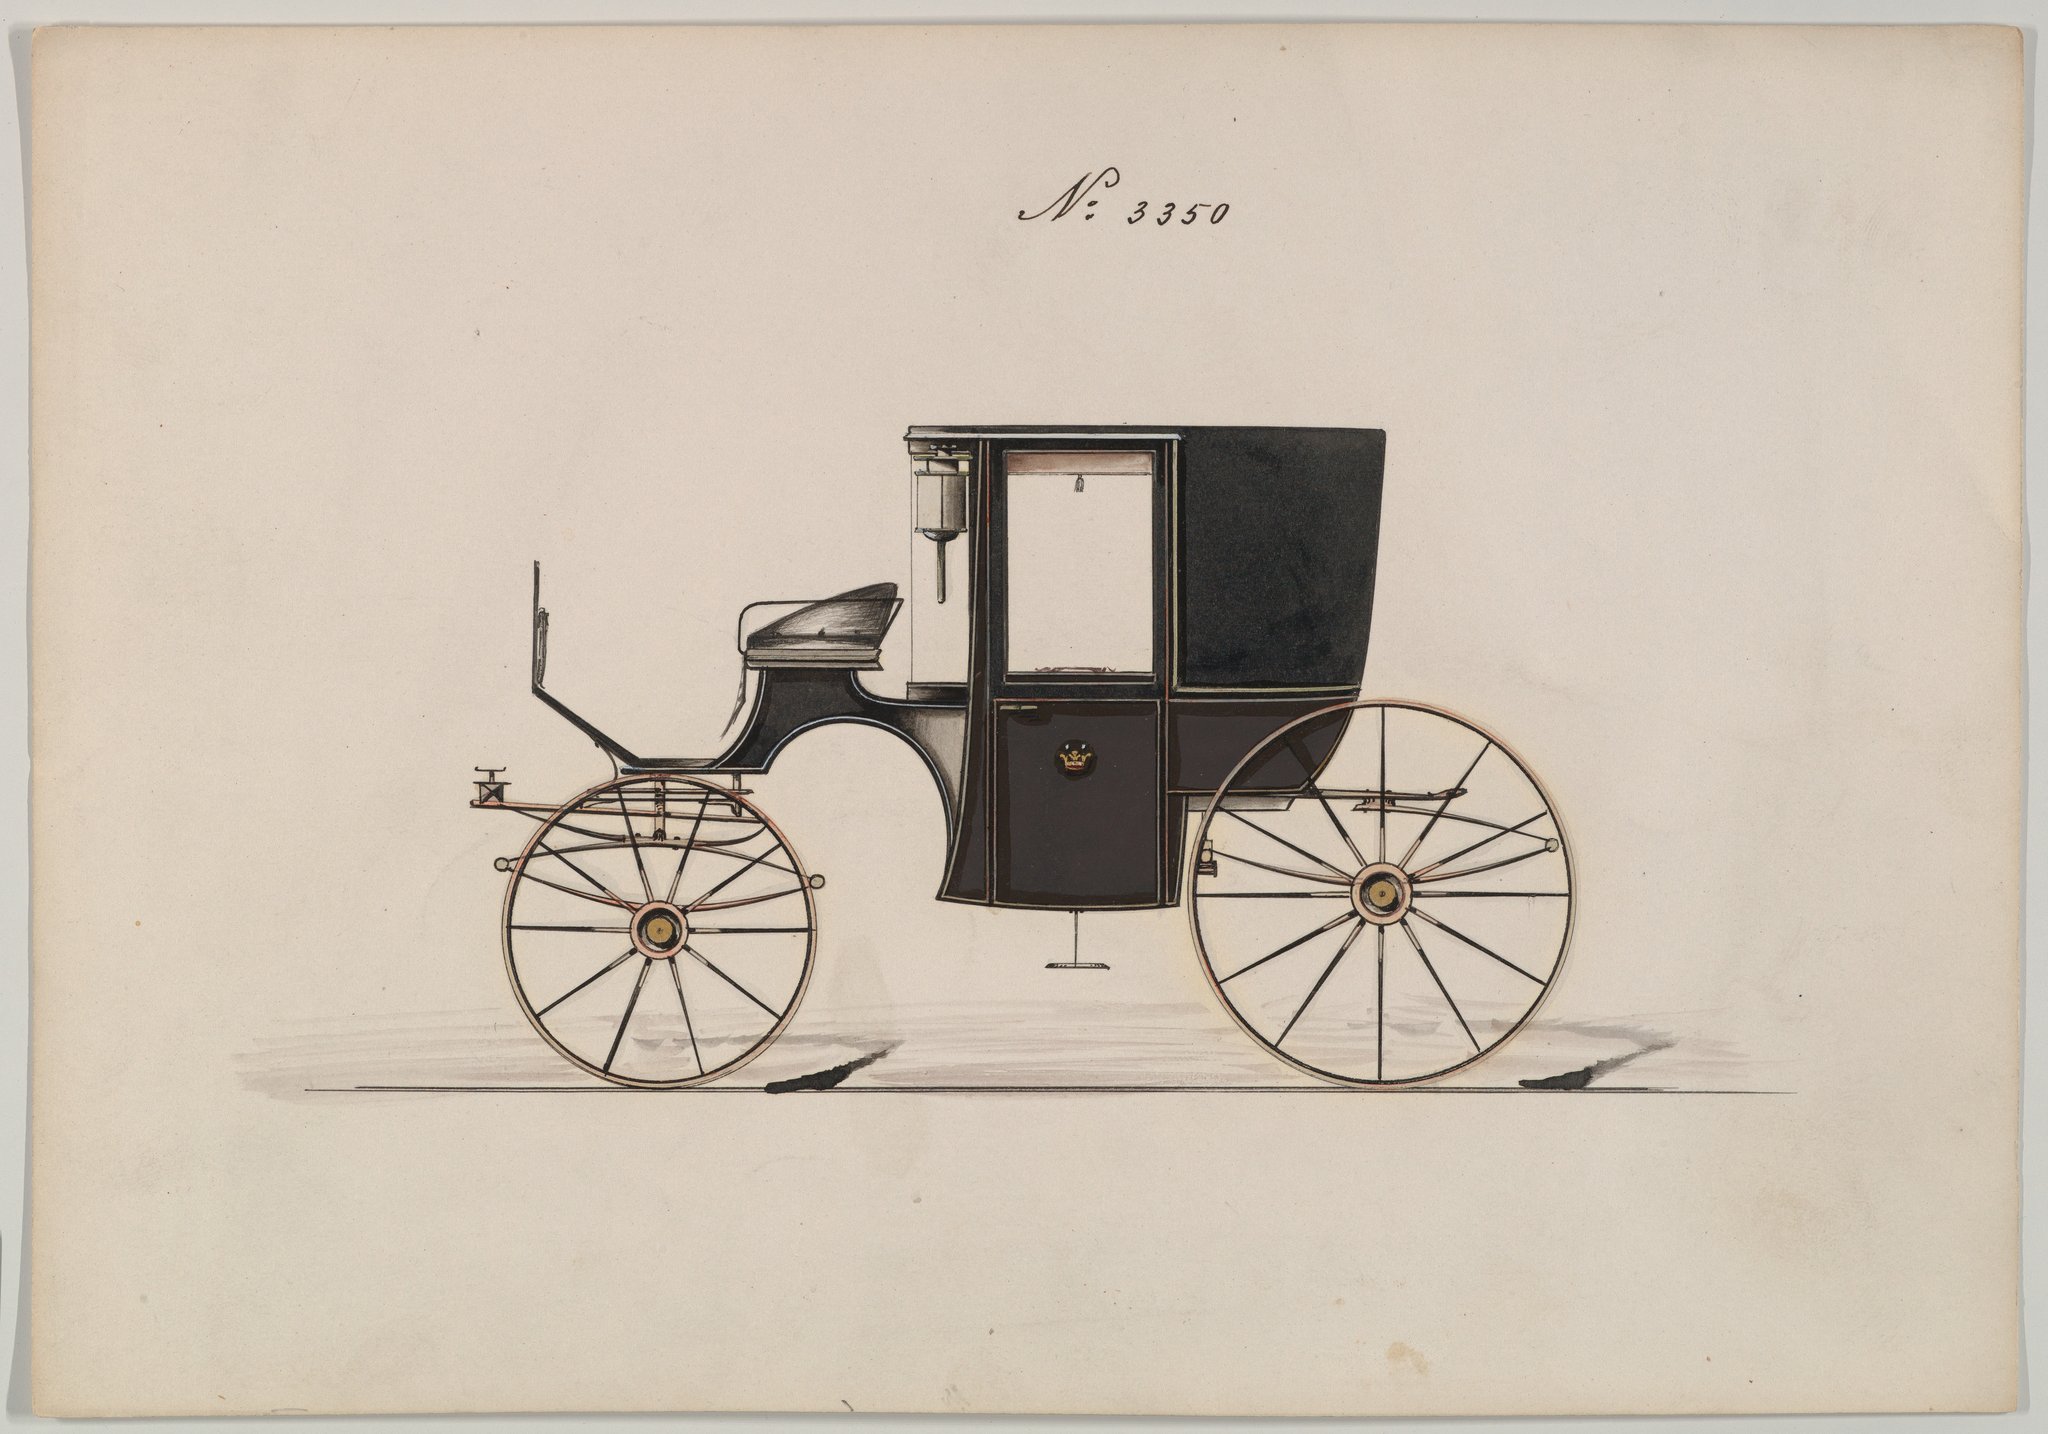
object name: drawing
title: Design for Coupé, no. 3350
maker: brewster & co.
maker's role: manufacturer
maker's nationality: american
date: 1877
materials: gouache, gum arabic, ink, watercolor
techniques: pen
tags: carriages